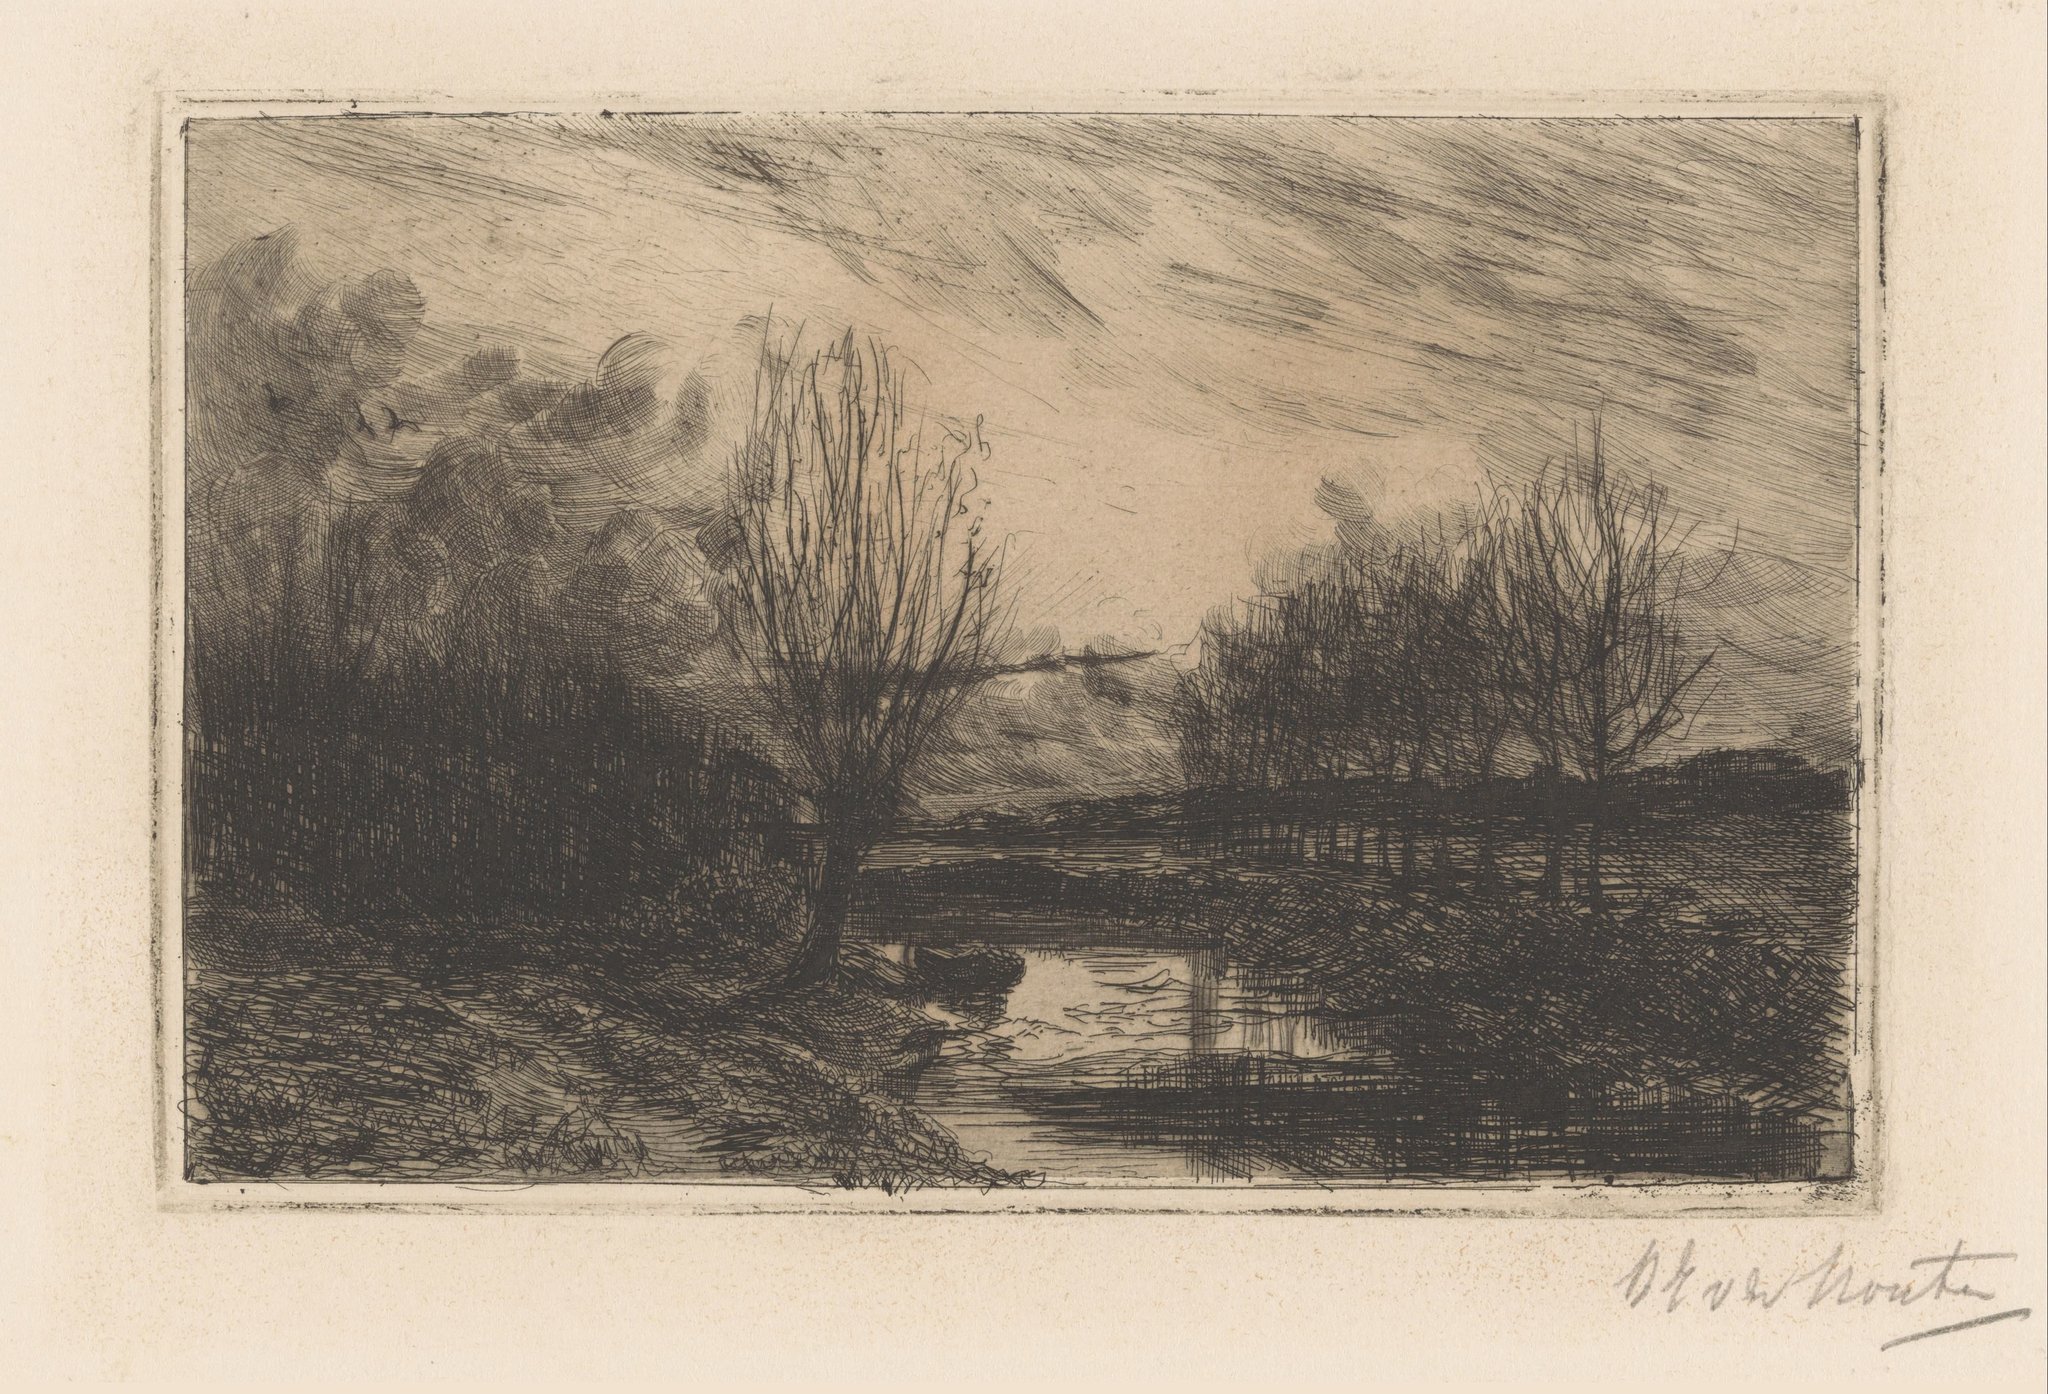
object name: print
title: Sloot met knotwilgen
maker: barbara elisabeth van houten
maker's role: draughtsman, print maker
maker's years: 1862-1950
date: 1877-1950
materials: paper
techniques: etching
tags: landscapes with waters, waterscapes, seascapes (in the temperate zone), trees: willow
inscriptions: collector's mark: Lugt 2228